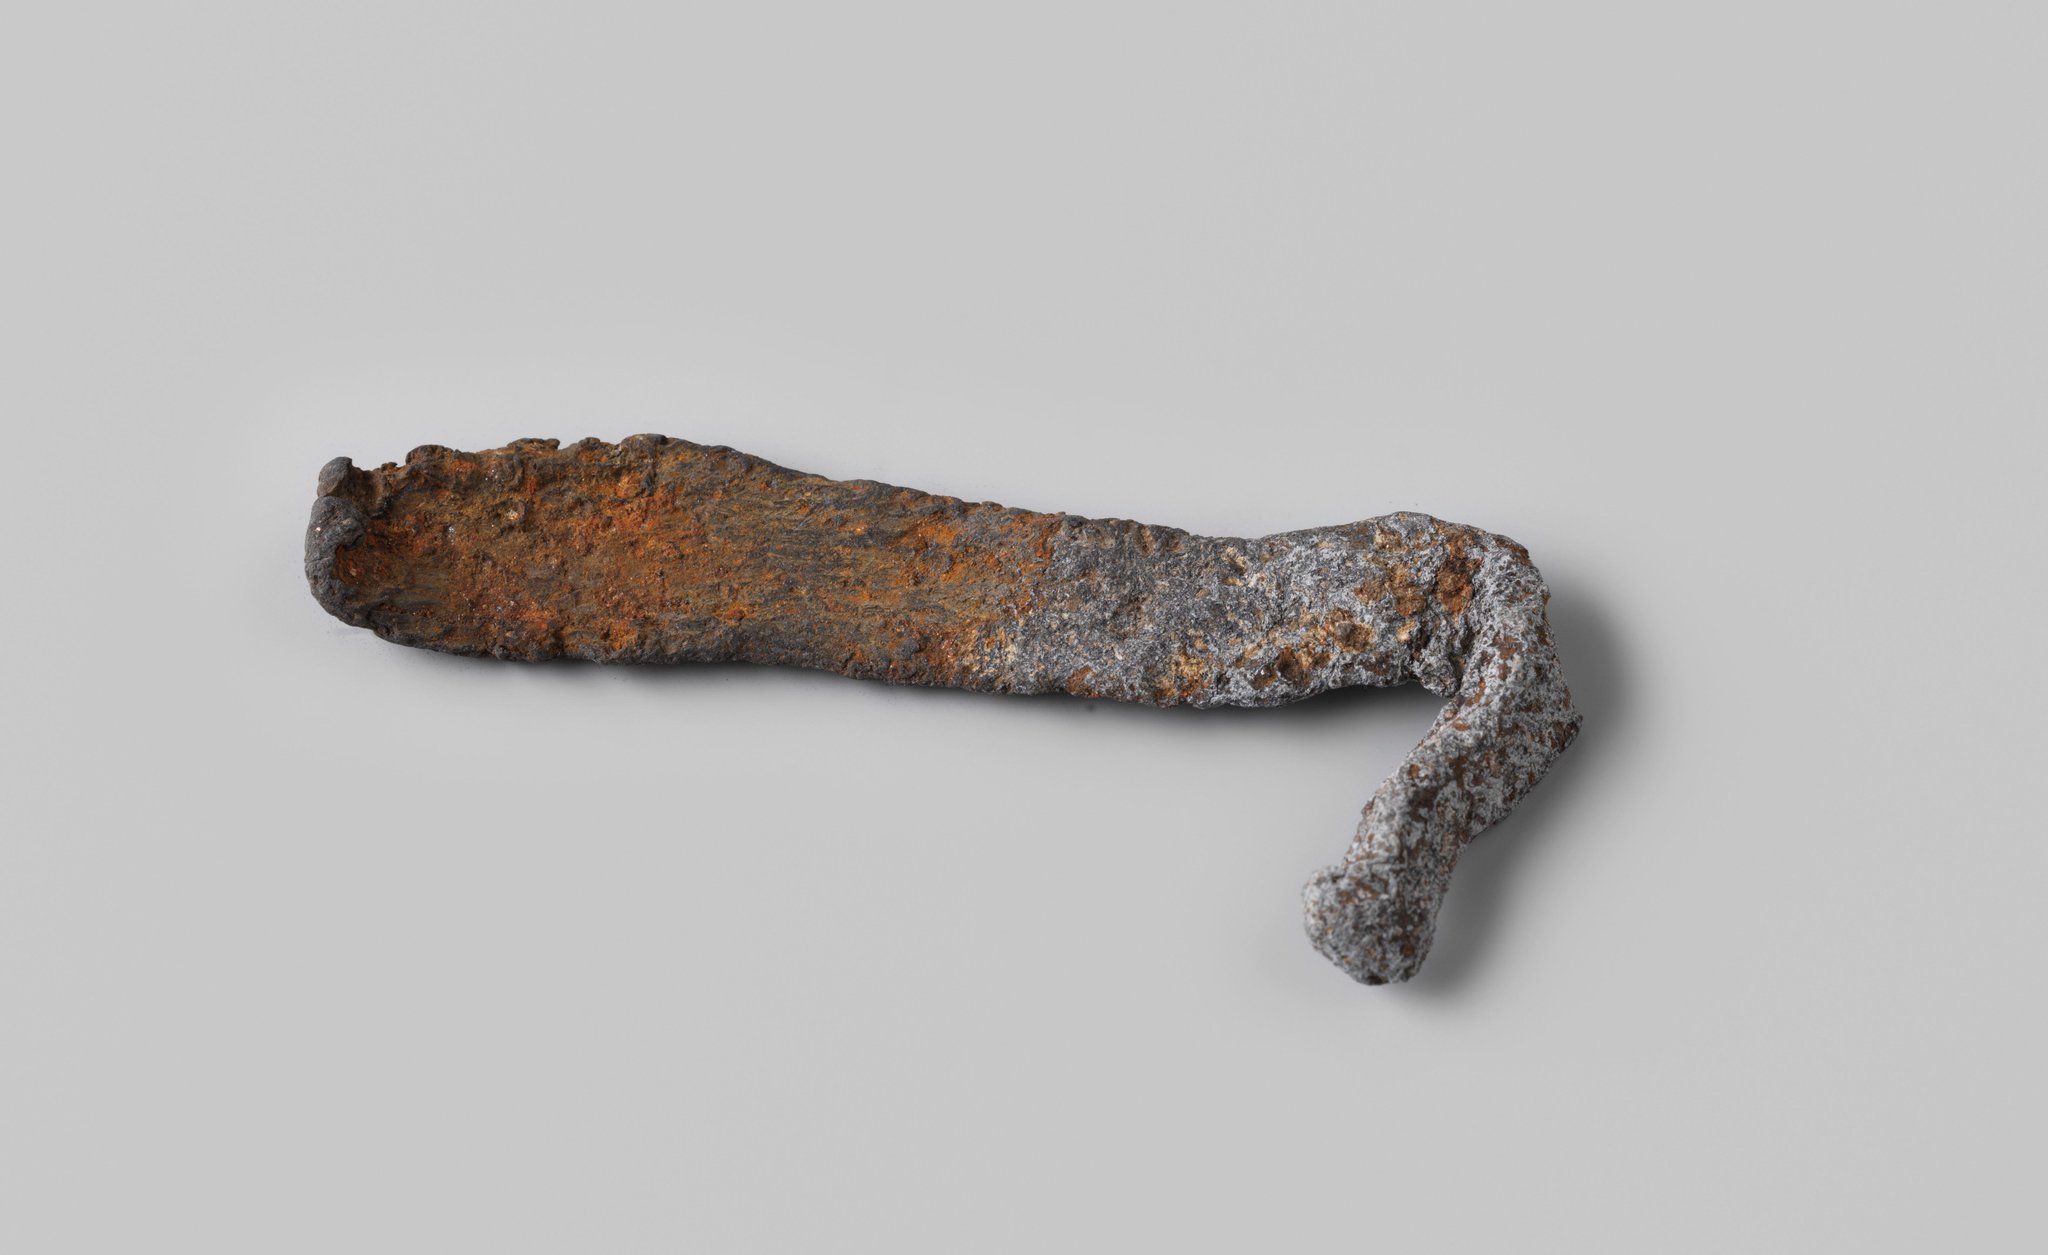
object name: strip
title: Fragment van lood uit het wrak van de Oost-Indiëvaarder Hollandia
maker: Anonymous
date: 1700-1743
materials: lead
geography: netherlands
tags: verenigde oostindische compagnie, hollandia (schip), annet